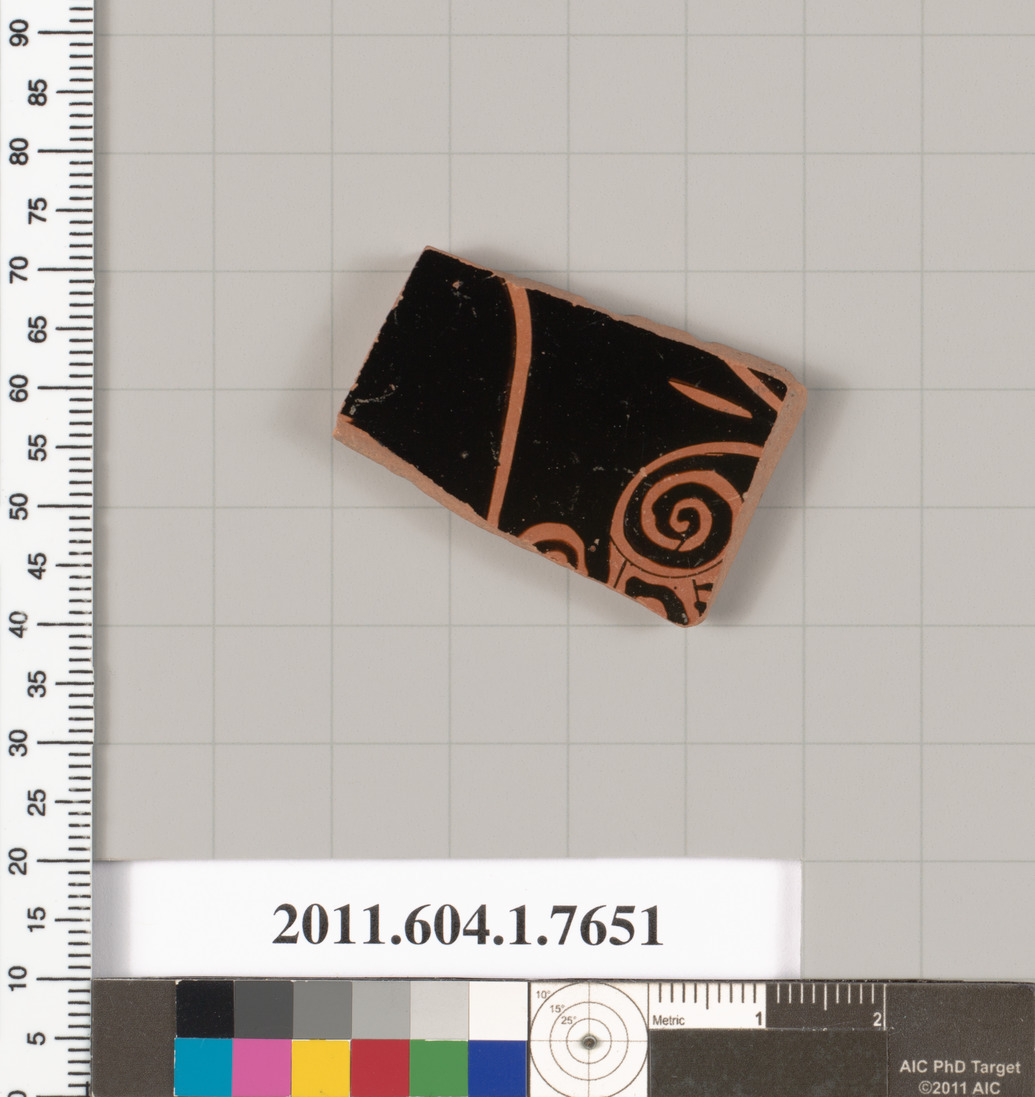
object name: kylix fragment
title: Terracotta fragment of a kylix (drinking cup)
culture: greek, attic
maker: euaion painter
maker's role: artist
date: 460-450 BCE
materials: terracotta